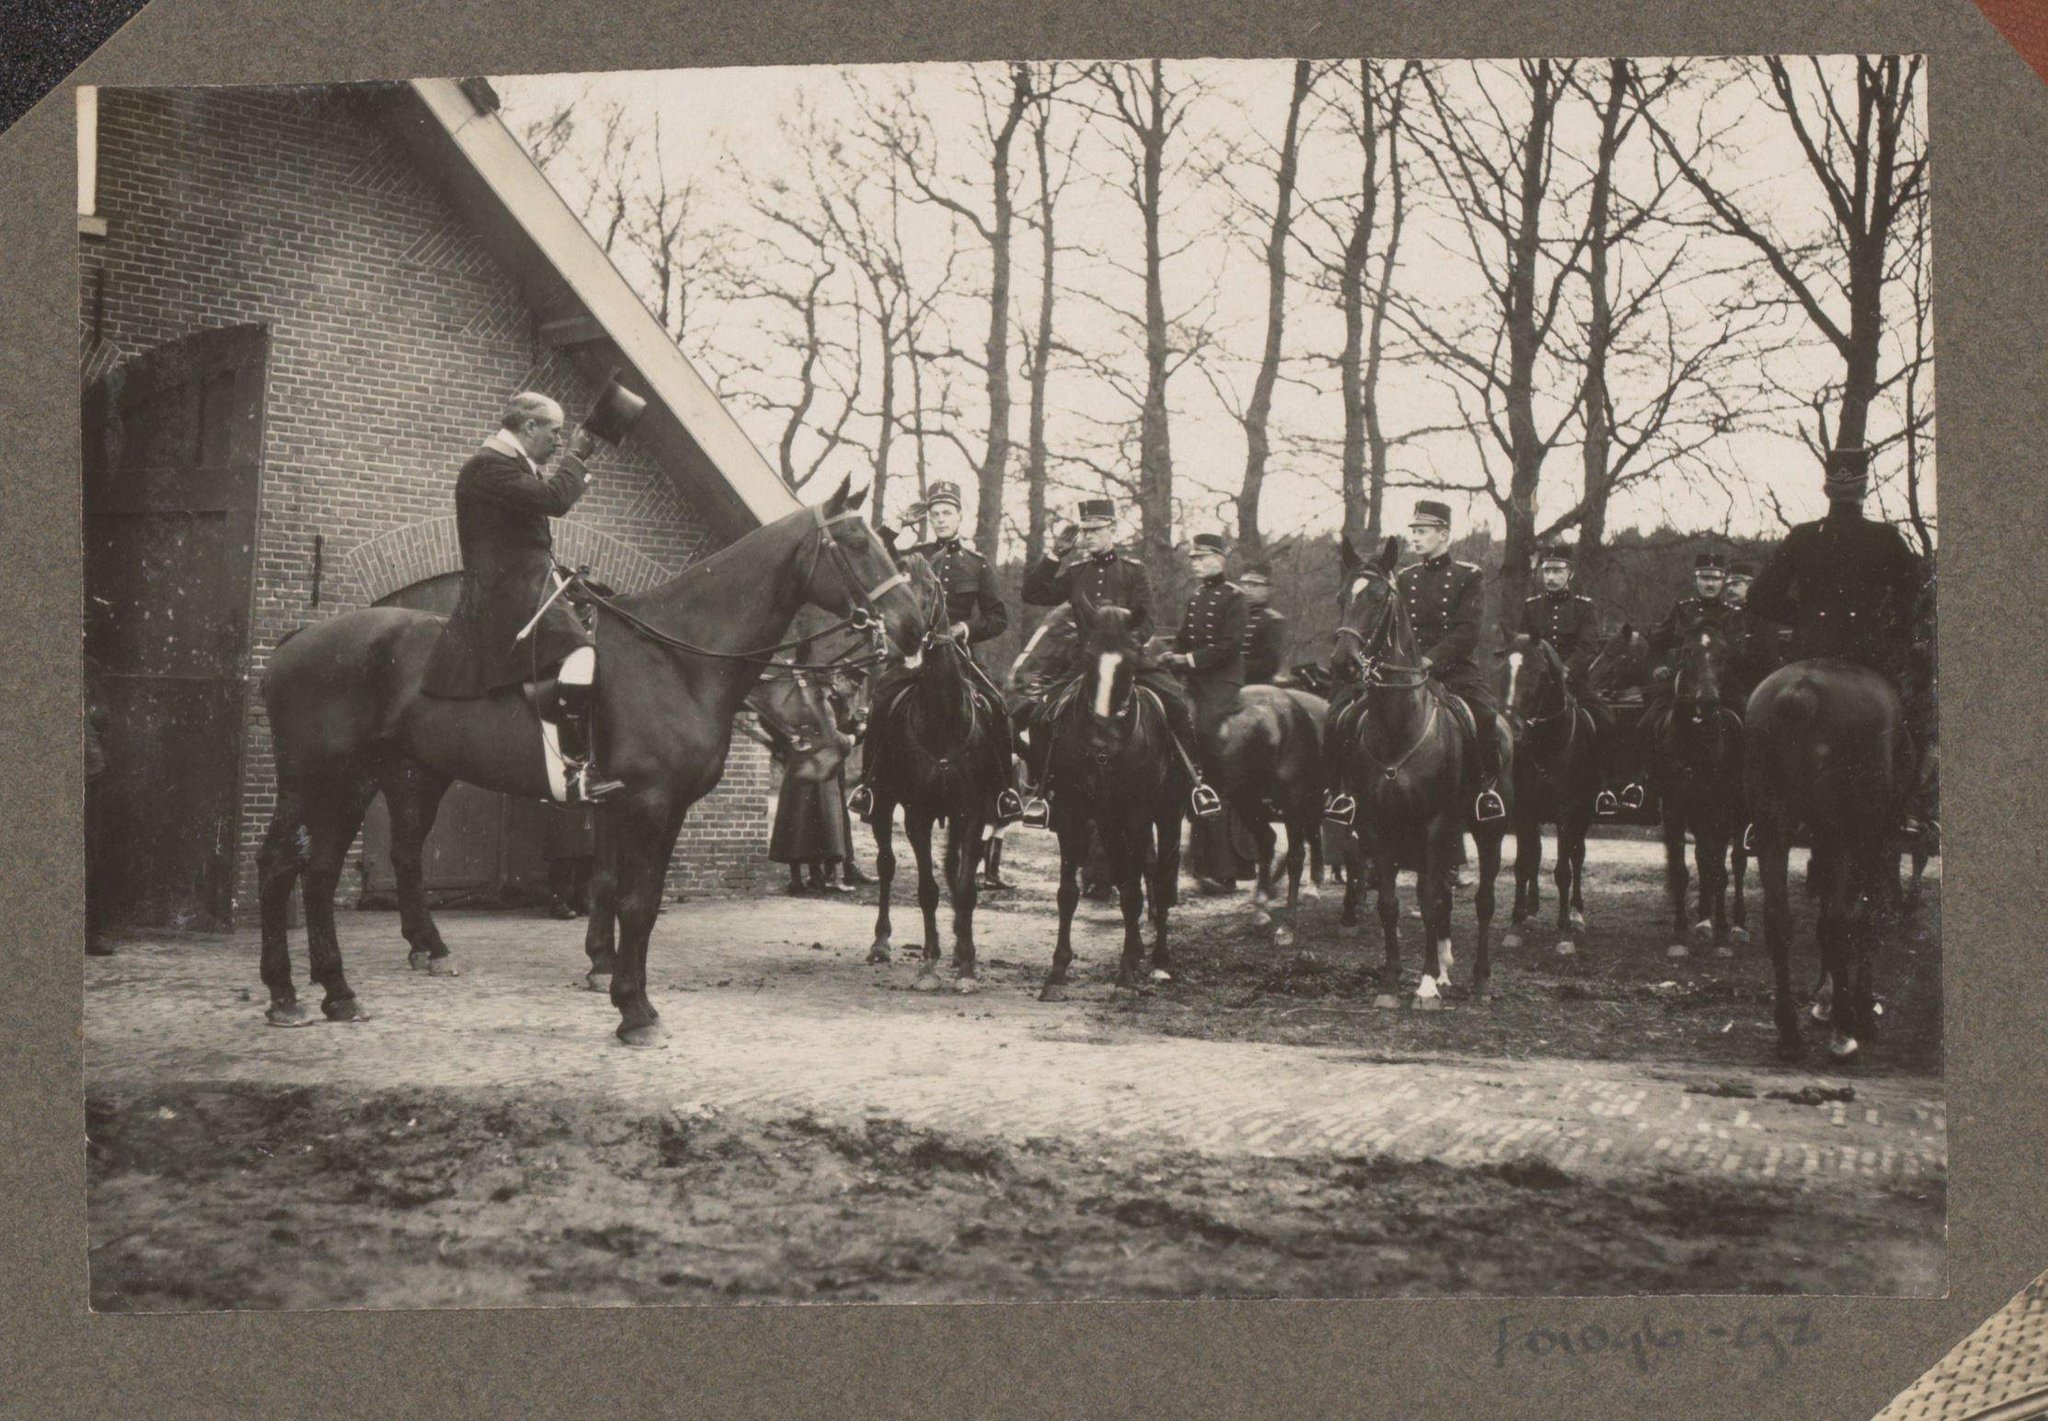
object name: photograph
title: Ruitertafereel op Koninklijke Houtvesterij Het Loo: ruiter groet militairen te paard bij een schuur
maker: Anonymous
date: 1900-1925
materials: photographic support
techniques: gelatin silver print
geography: het loo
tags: riding a horse, ass, or mule; rider, horseman, hunting, chase, baring the head, lifting one's hat, hunting-ground, (military) uniforms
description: Onderdeel van Fotoalbum van de heer Brams, opperhoutvester van koningin Wilhelmina op Koninklijke Houtvesterij Het Loo.